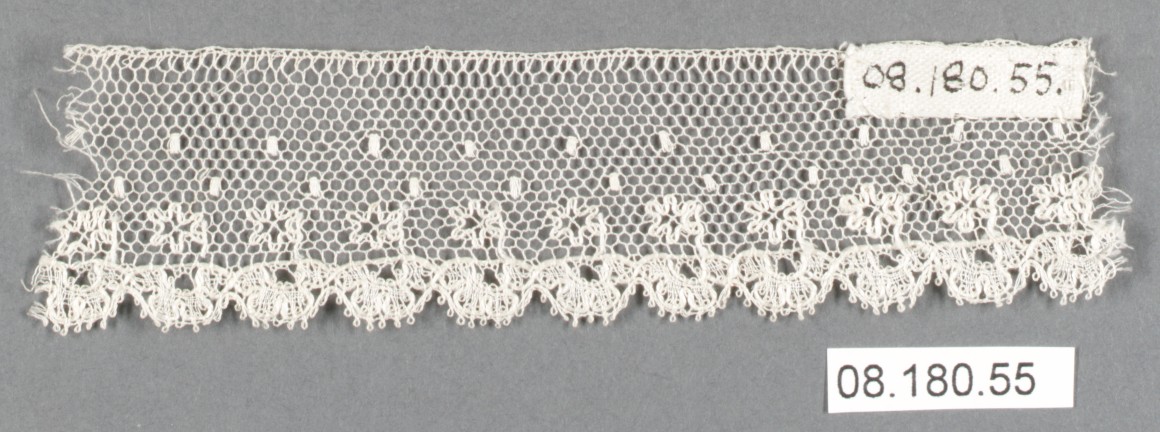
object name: baby lace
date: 1801-1900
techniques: lace